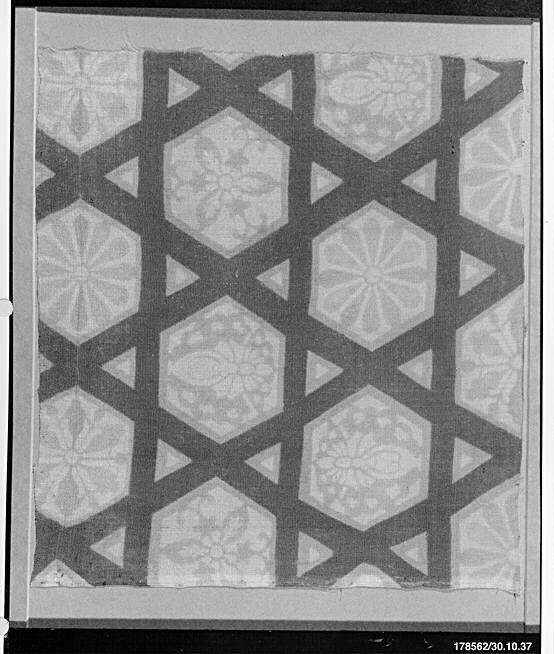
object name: piece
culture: japanese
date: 1701-1900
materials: silk